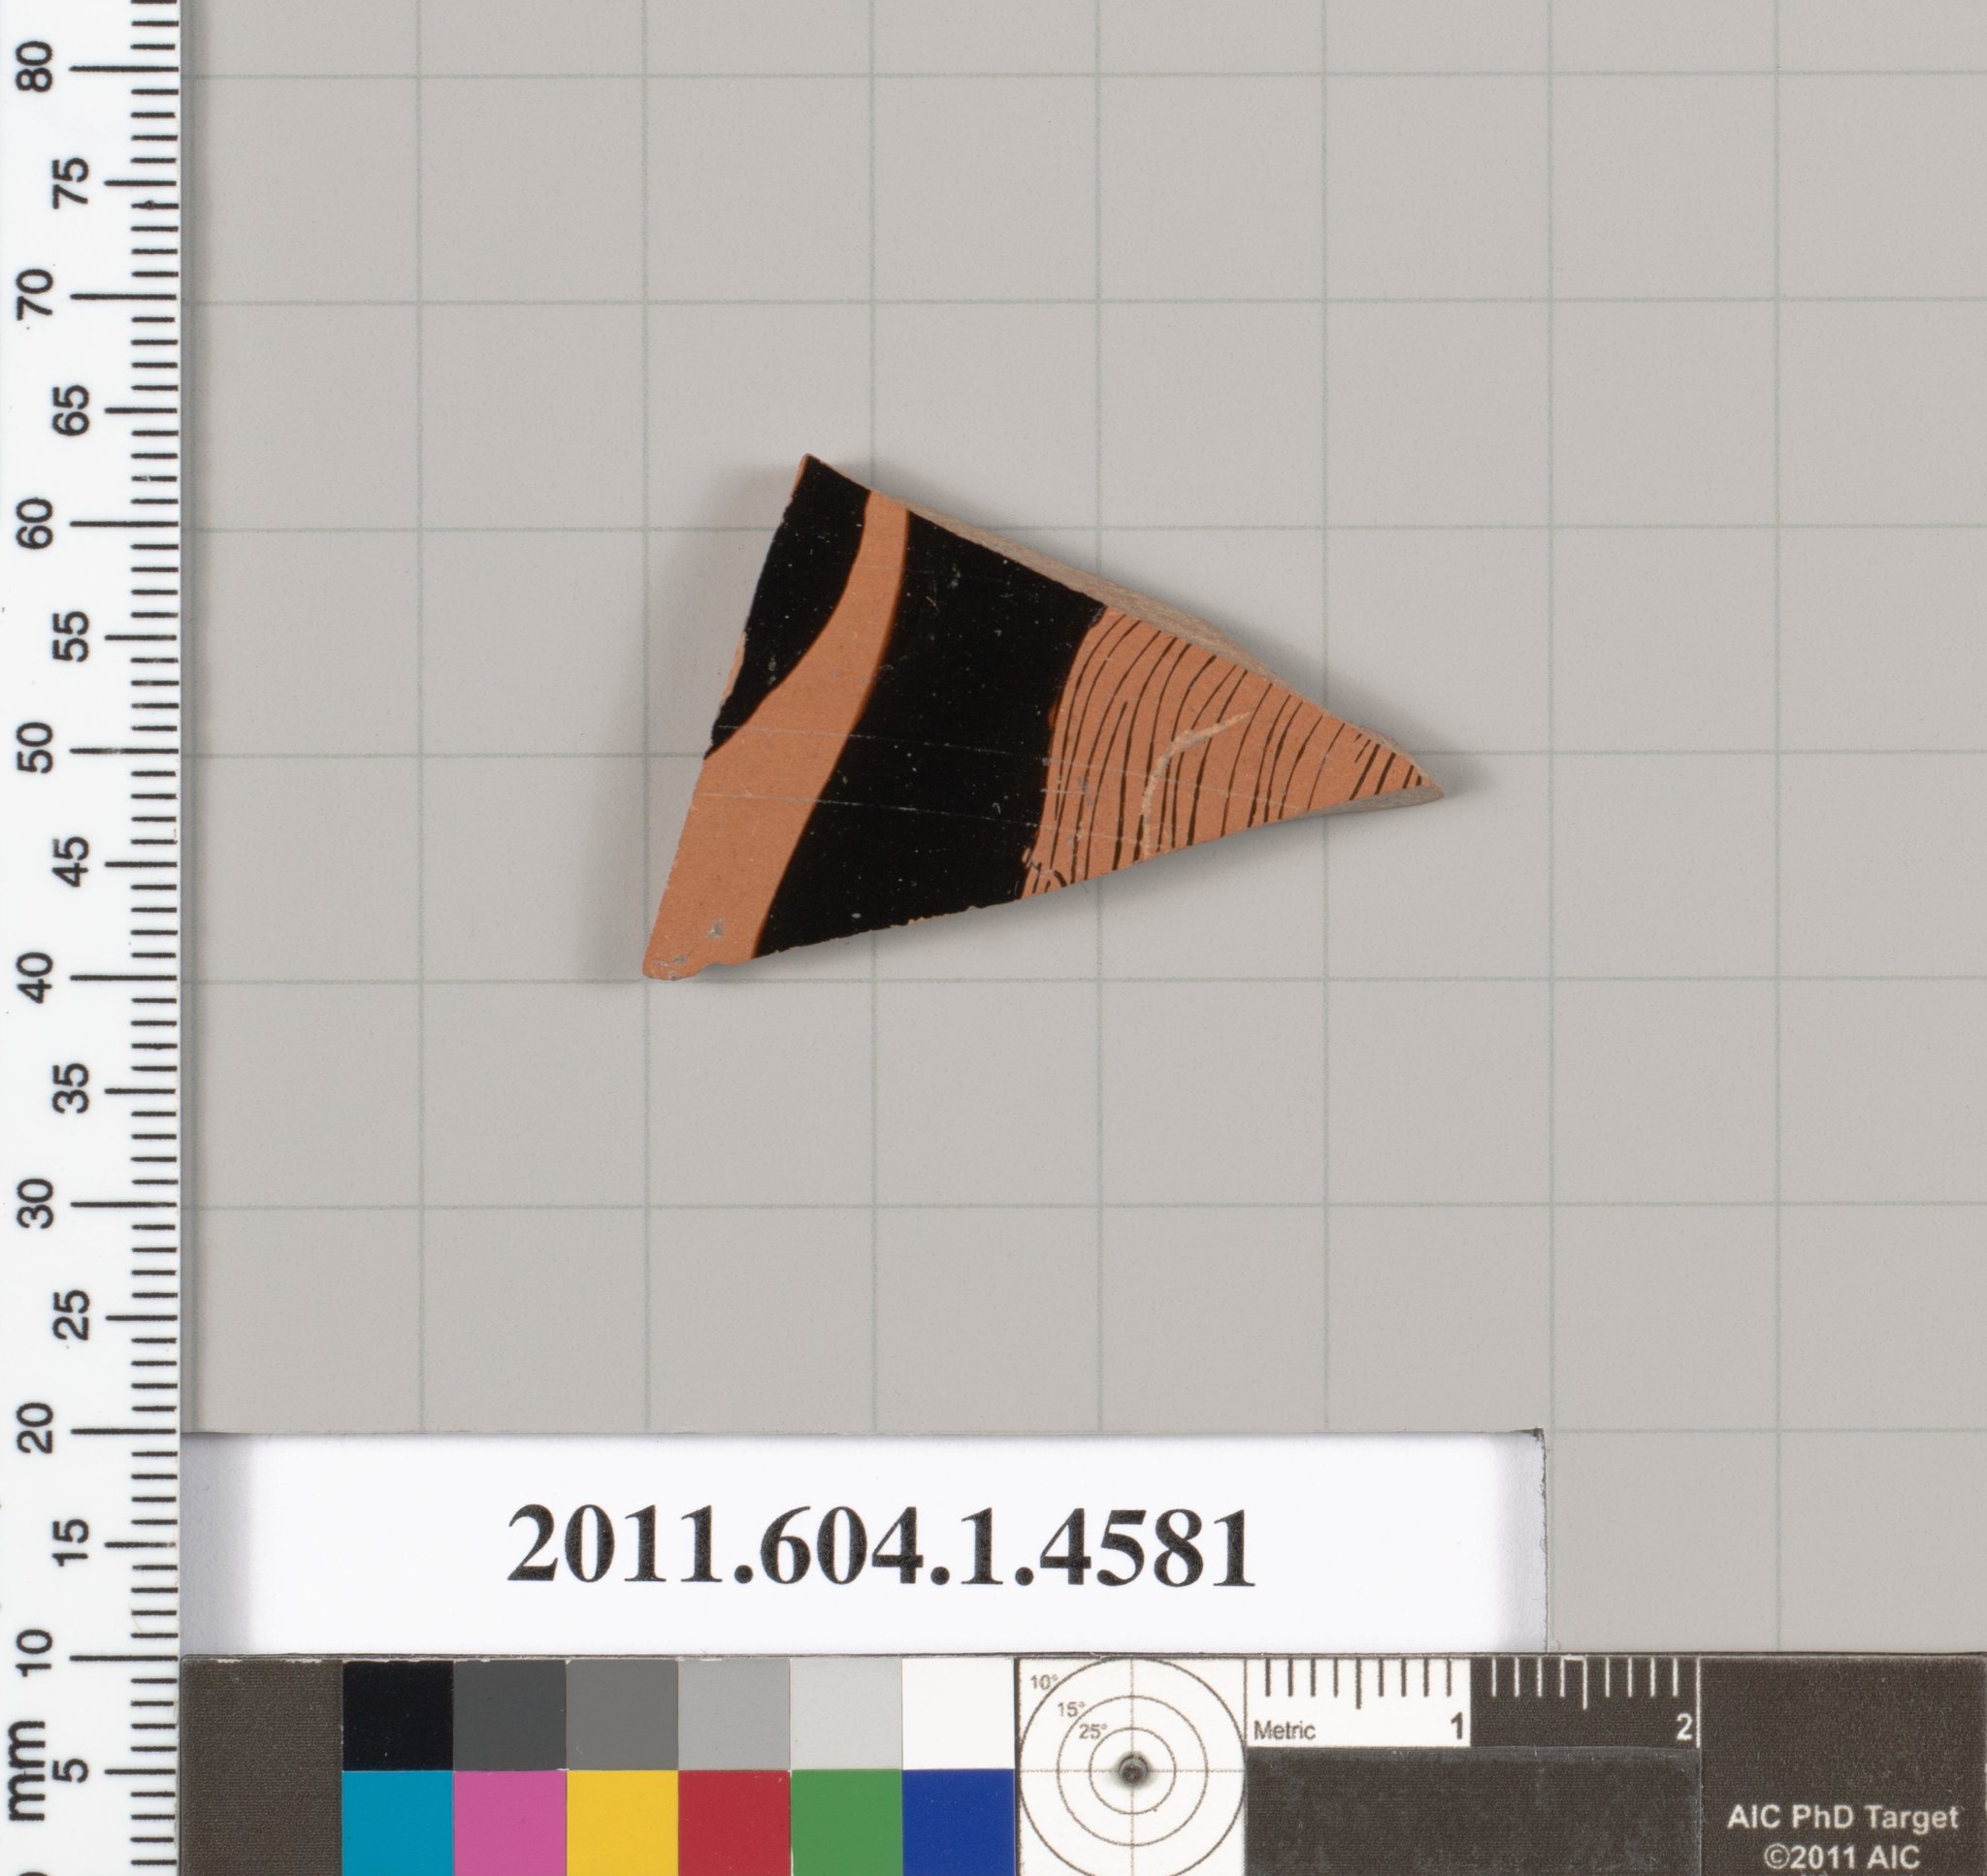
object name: kylix fragment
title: Terracotta fragment of a kylix (drinking cup)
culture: greek, attic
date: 480-470 BCE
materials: terracotta